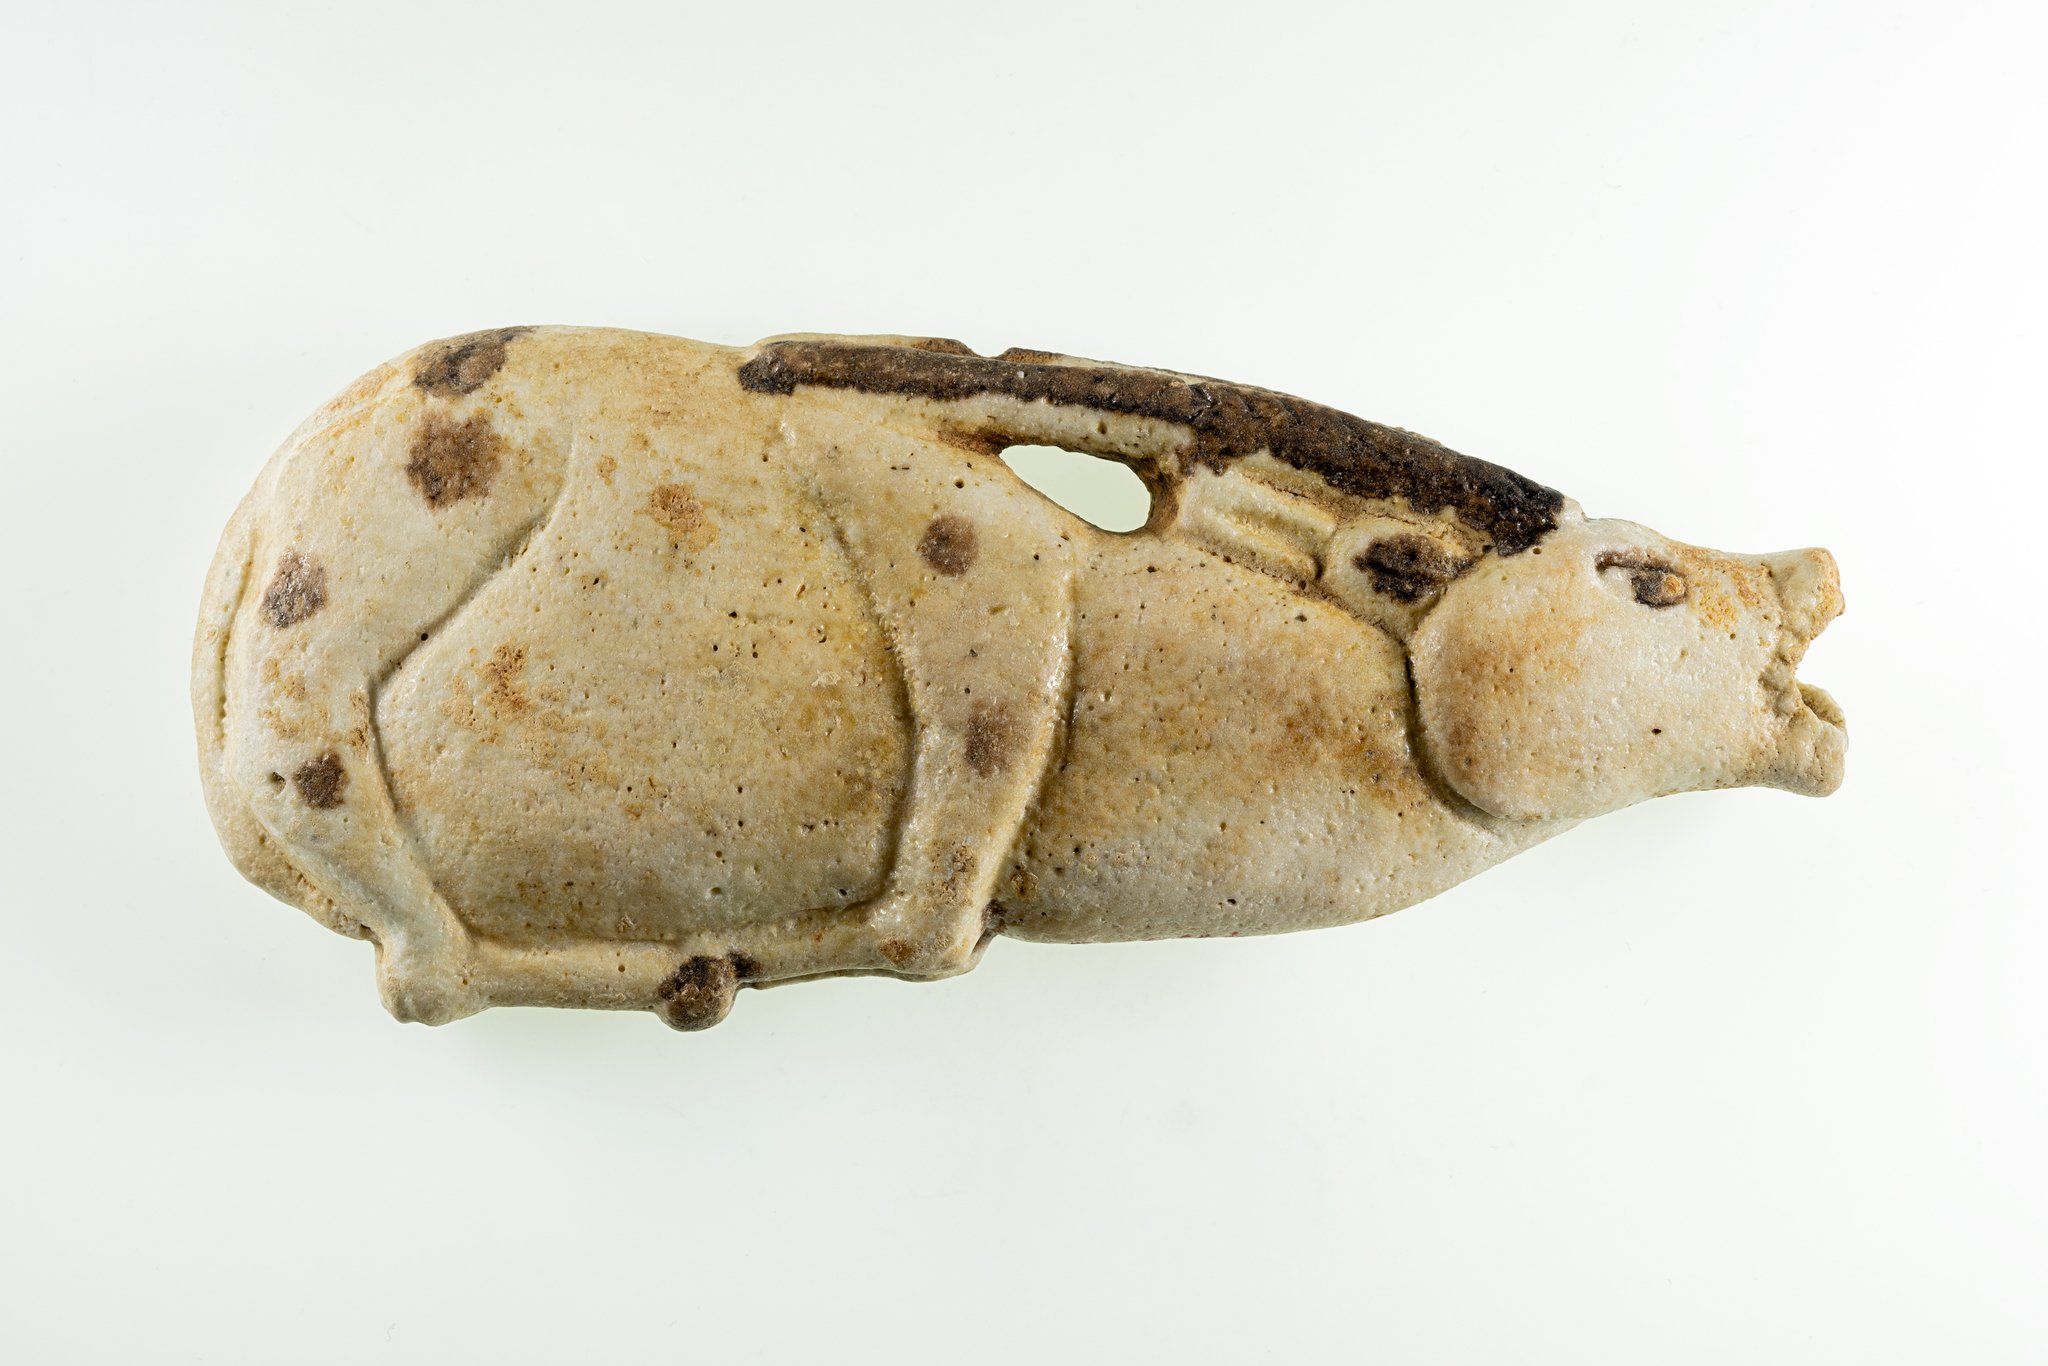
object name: dish, oryx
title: Oryx dish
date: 1070-664 BCE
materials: faience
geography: egypt